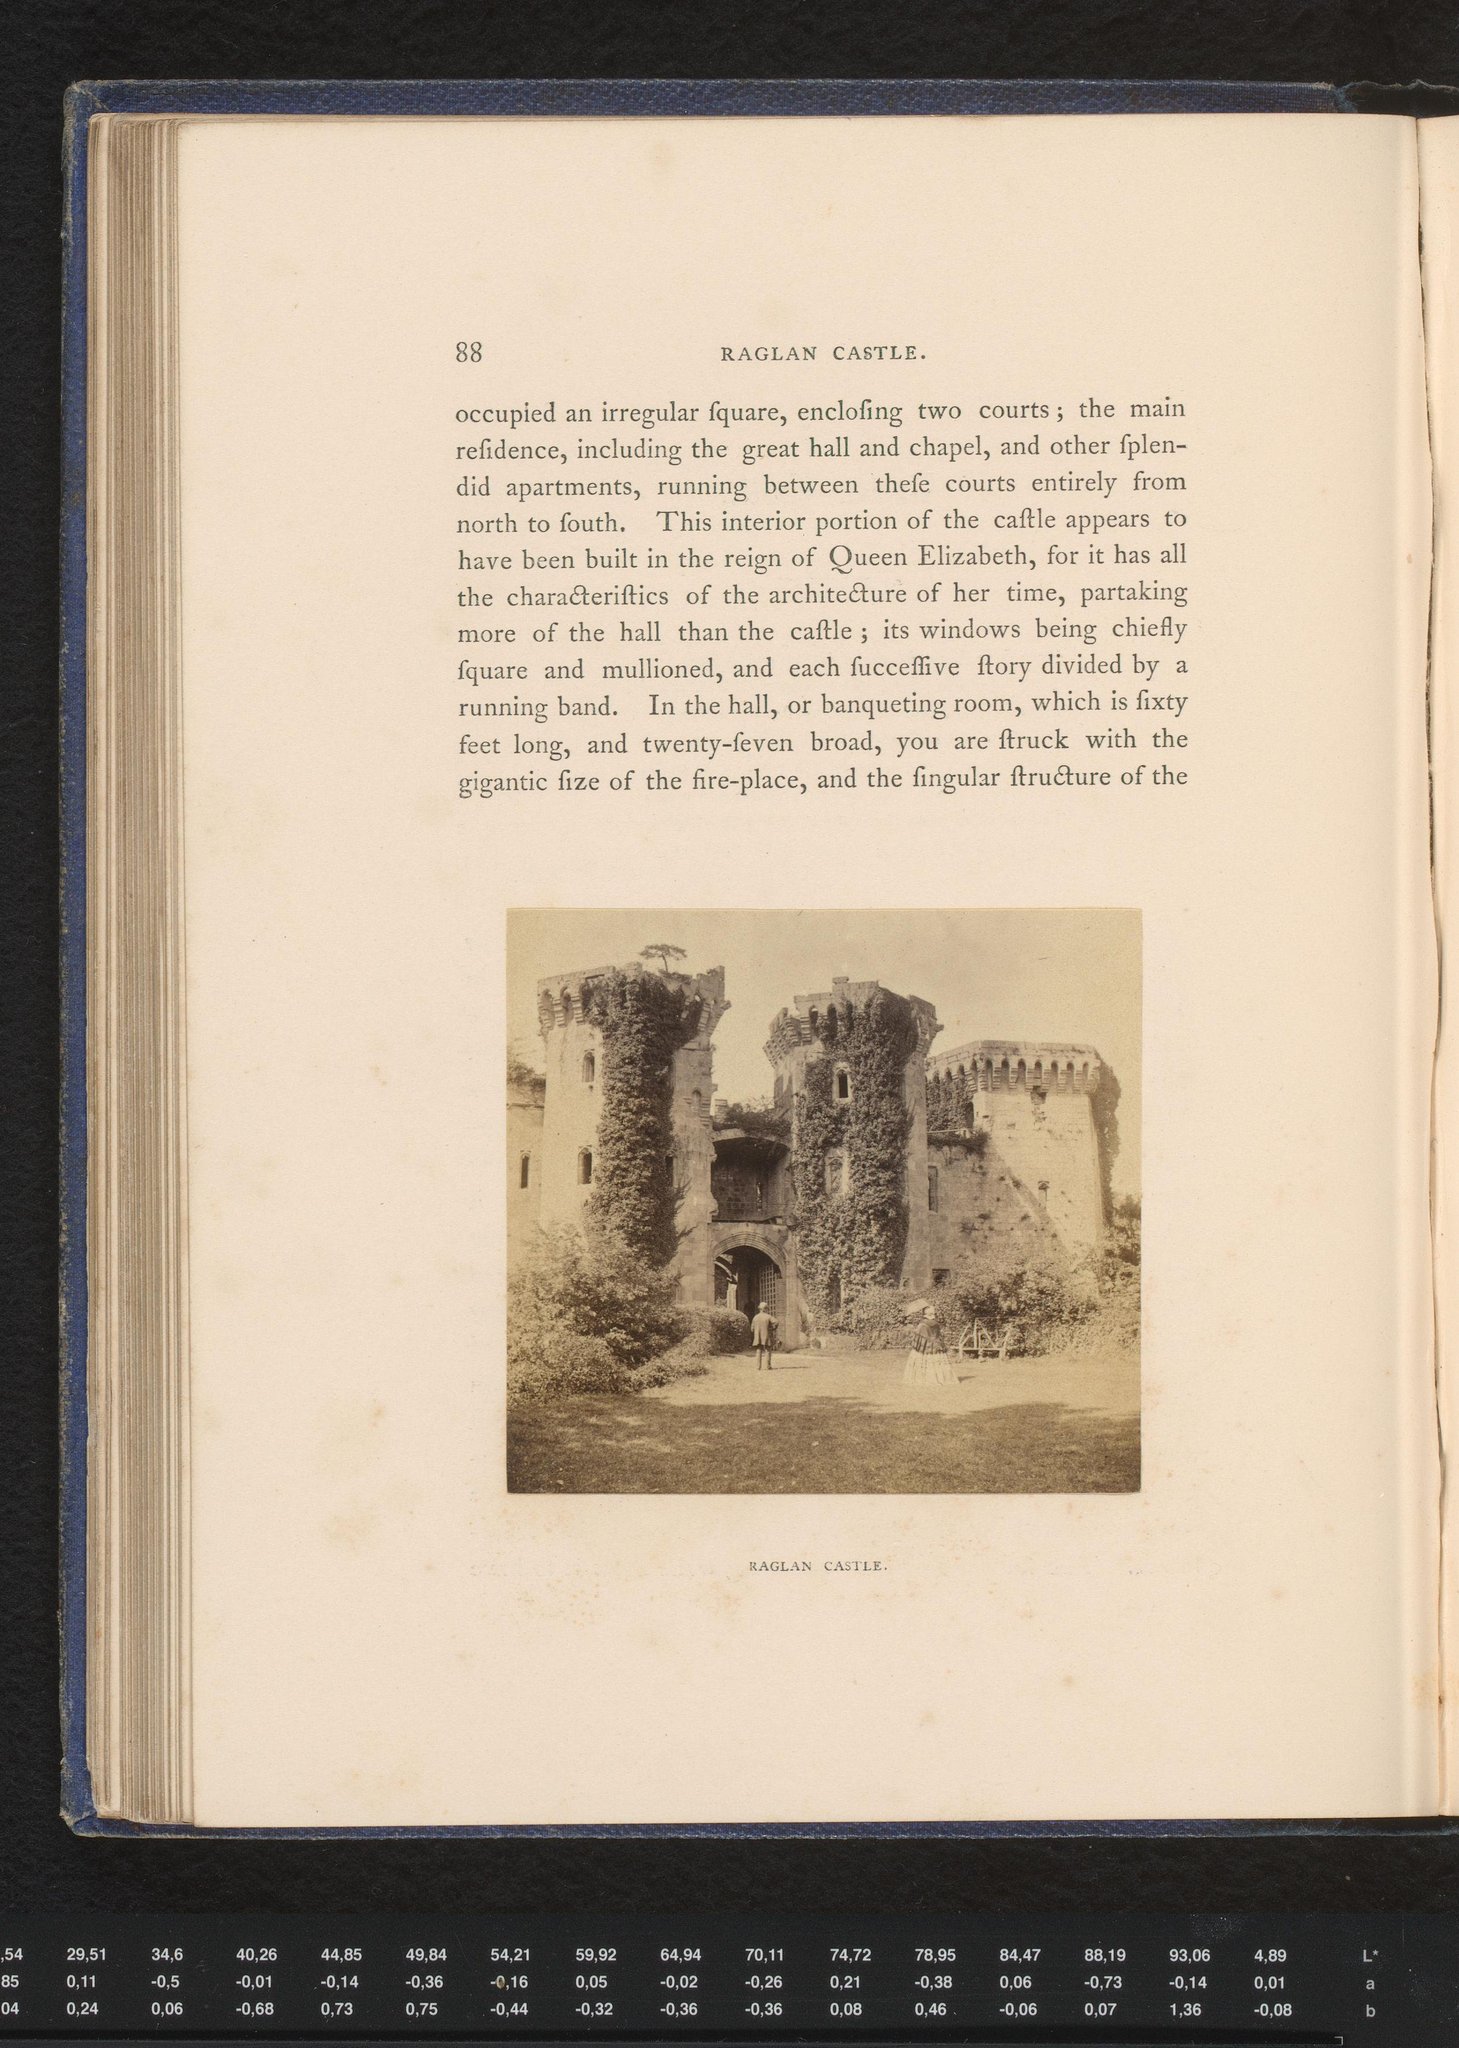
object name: page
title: Raglan Castle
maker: francis bedford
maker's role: print maker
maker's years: 1815-1894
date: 1857-1862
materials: paper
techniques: albumen print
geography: monmouthshire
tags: castle